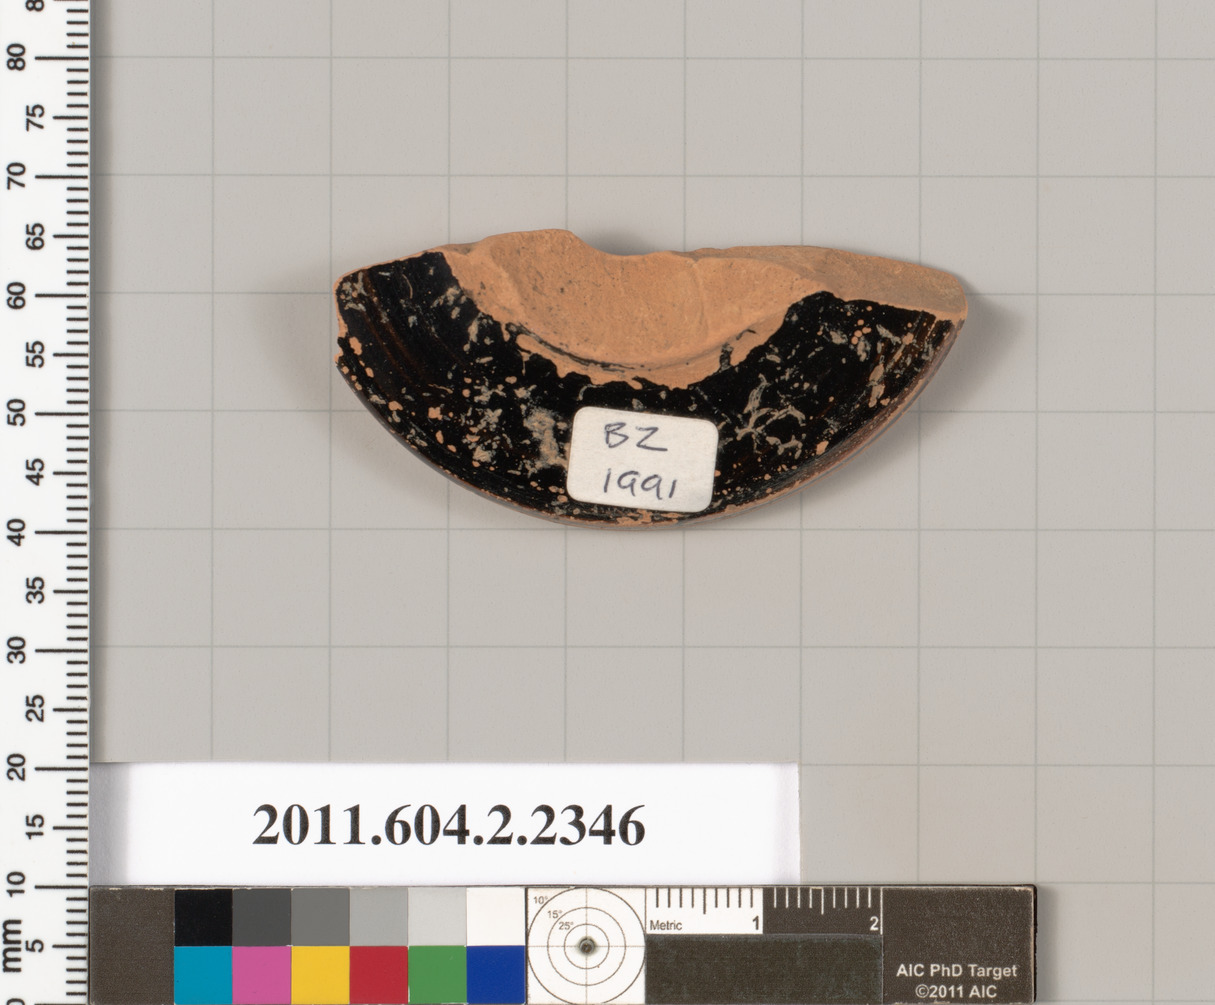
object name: lekythos fragment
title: Terracotta fragment of a lekythos (oil flask)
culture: greek, attic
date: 600-401 BCE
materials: terracotta